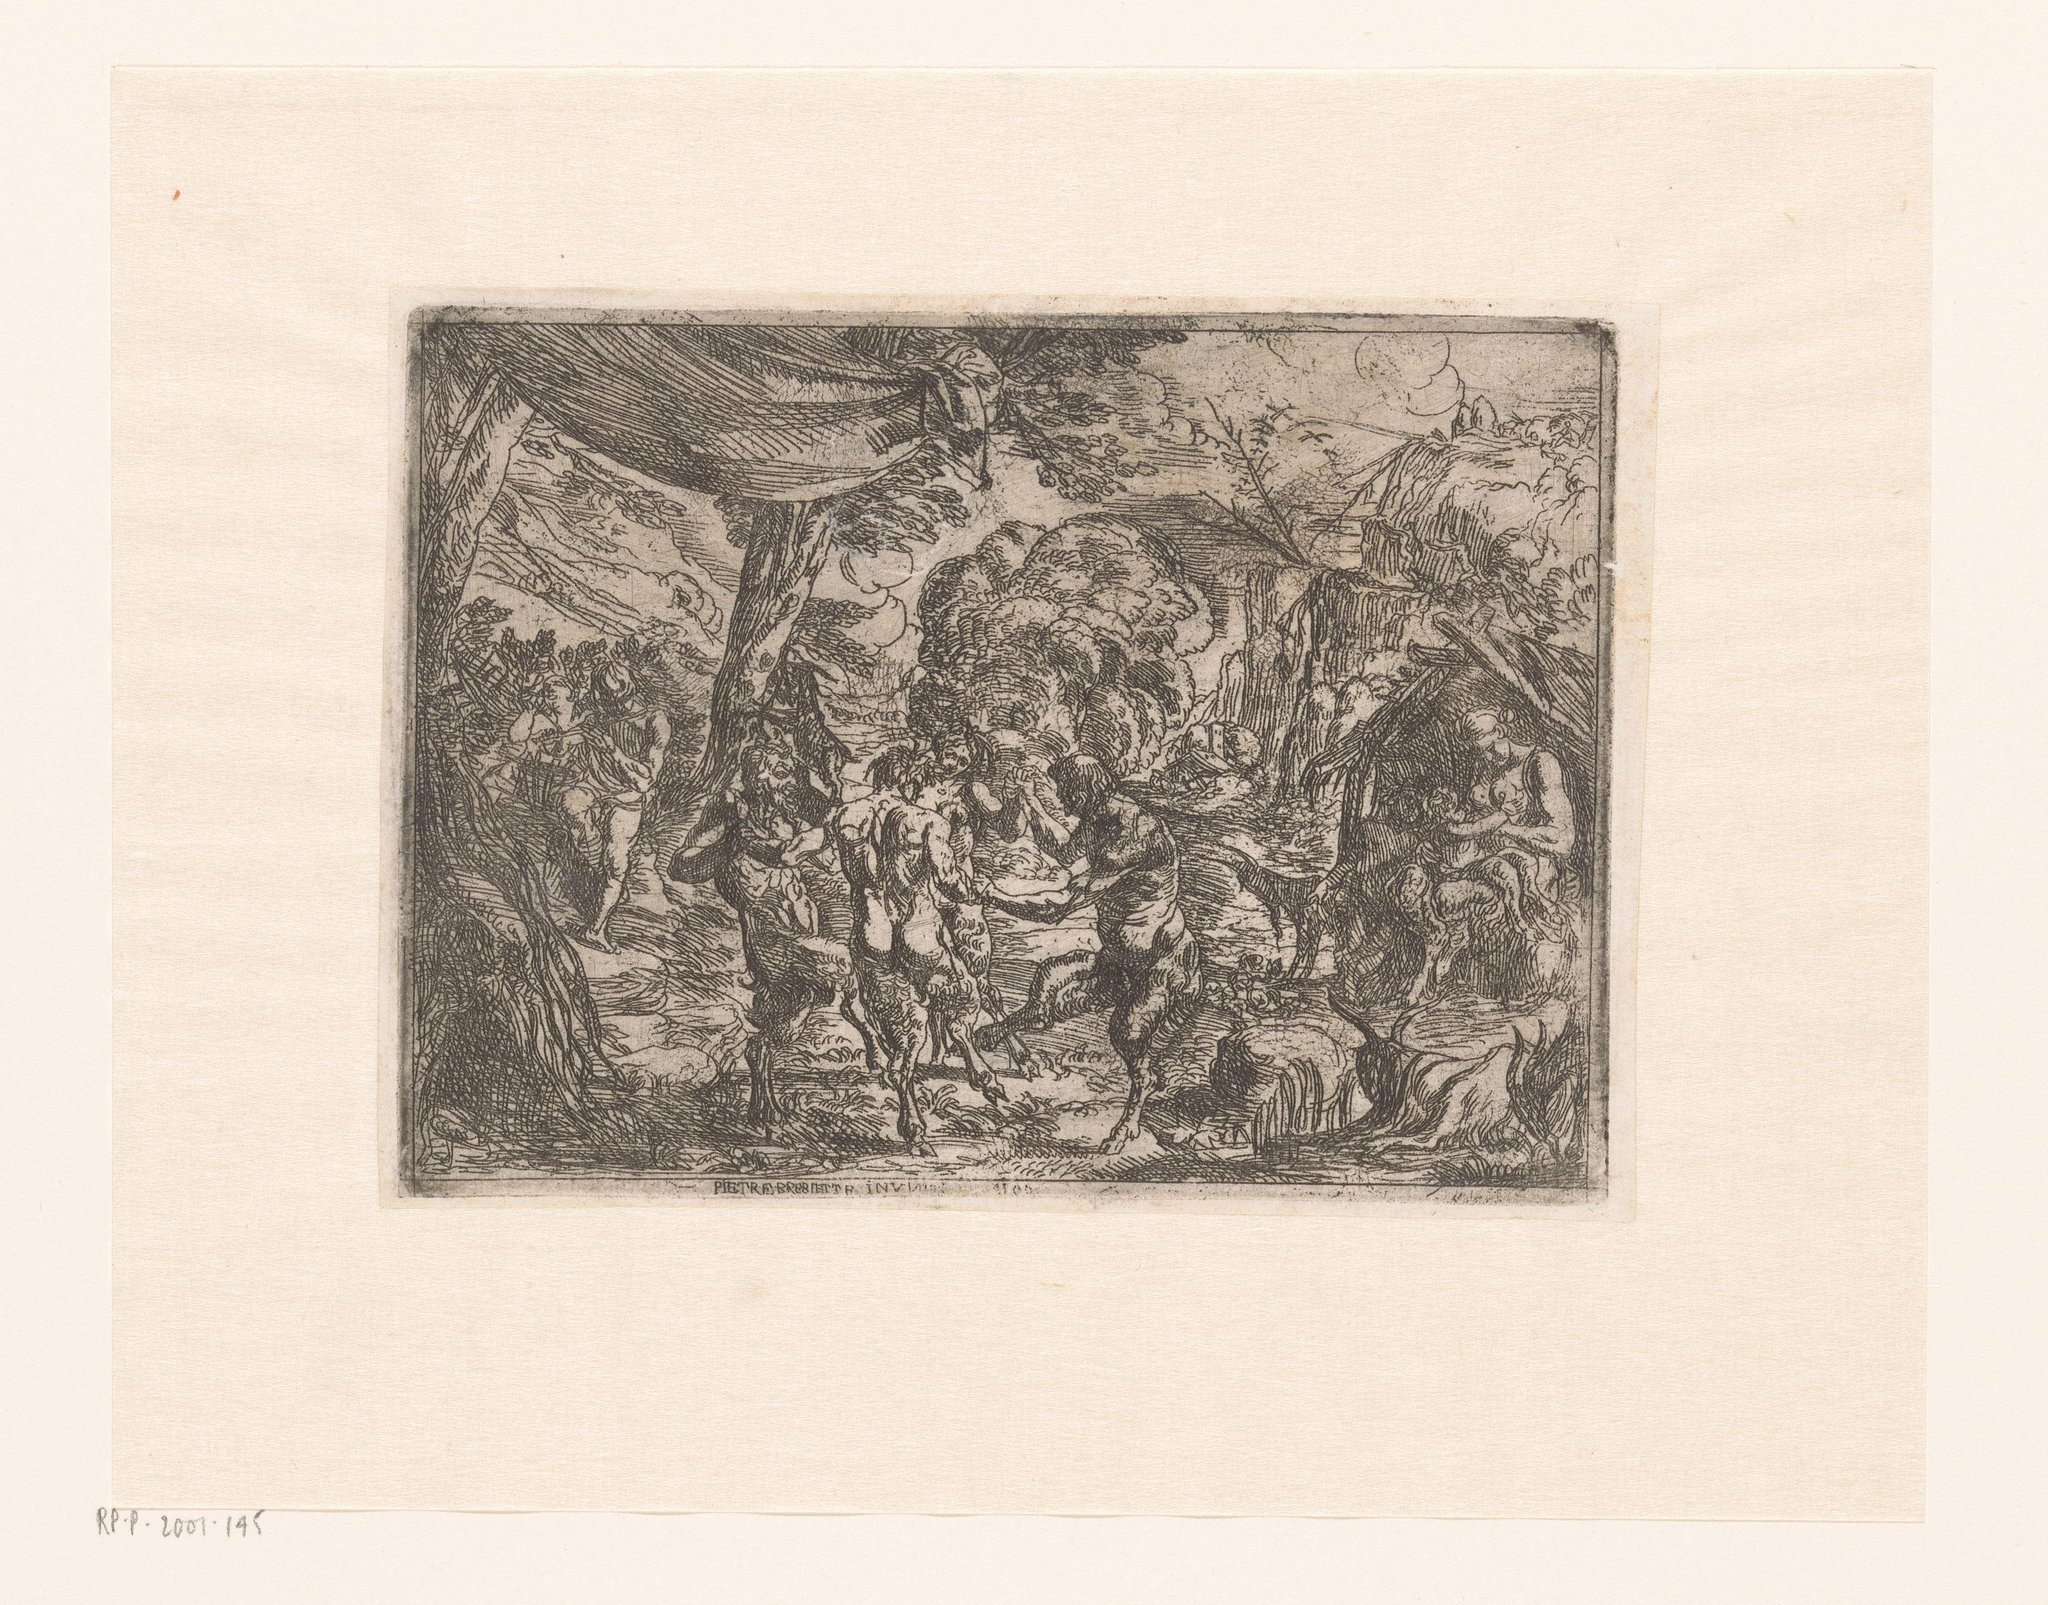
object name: print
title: Dansende nimfen en saters in een landschap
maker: pierre brebiette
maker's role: draughtsman, print maker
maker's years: 1598-1650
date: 1608-1650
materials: paper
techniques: etching, intaglio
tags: satyrs, fauns, sileni, nymphs (in general); 'ninfe in commune' (ripa), group dancing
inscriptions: collector's mark: Lugt 2760, collector's mark: Lugt 2228